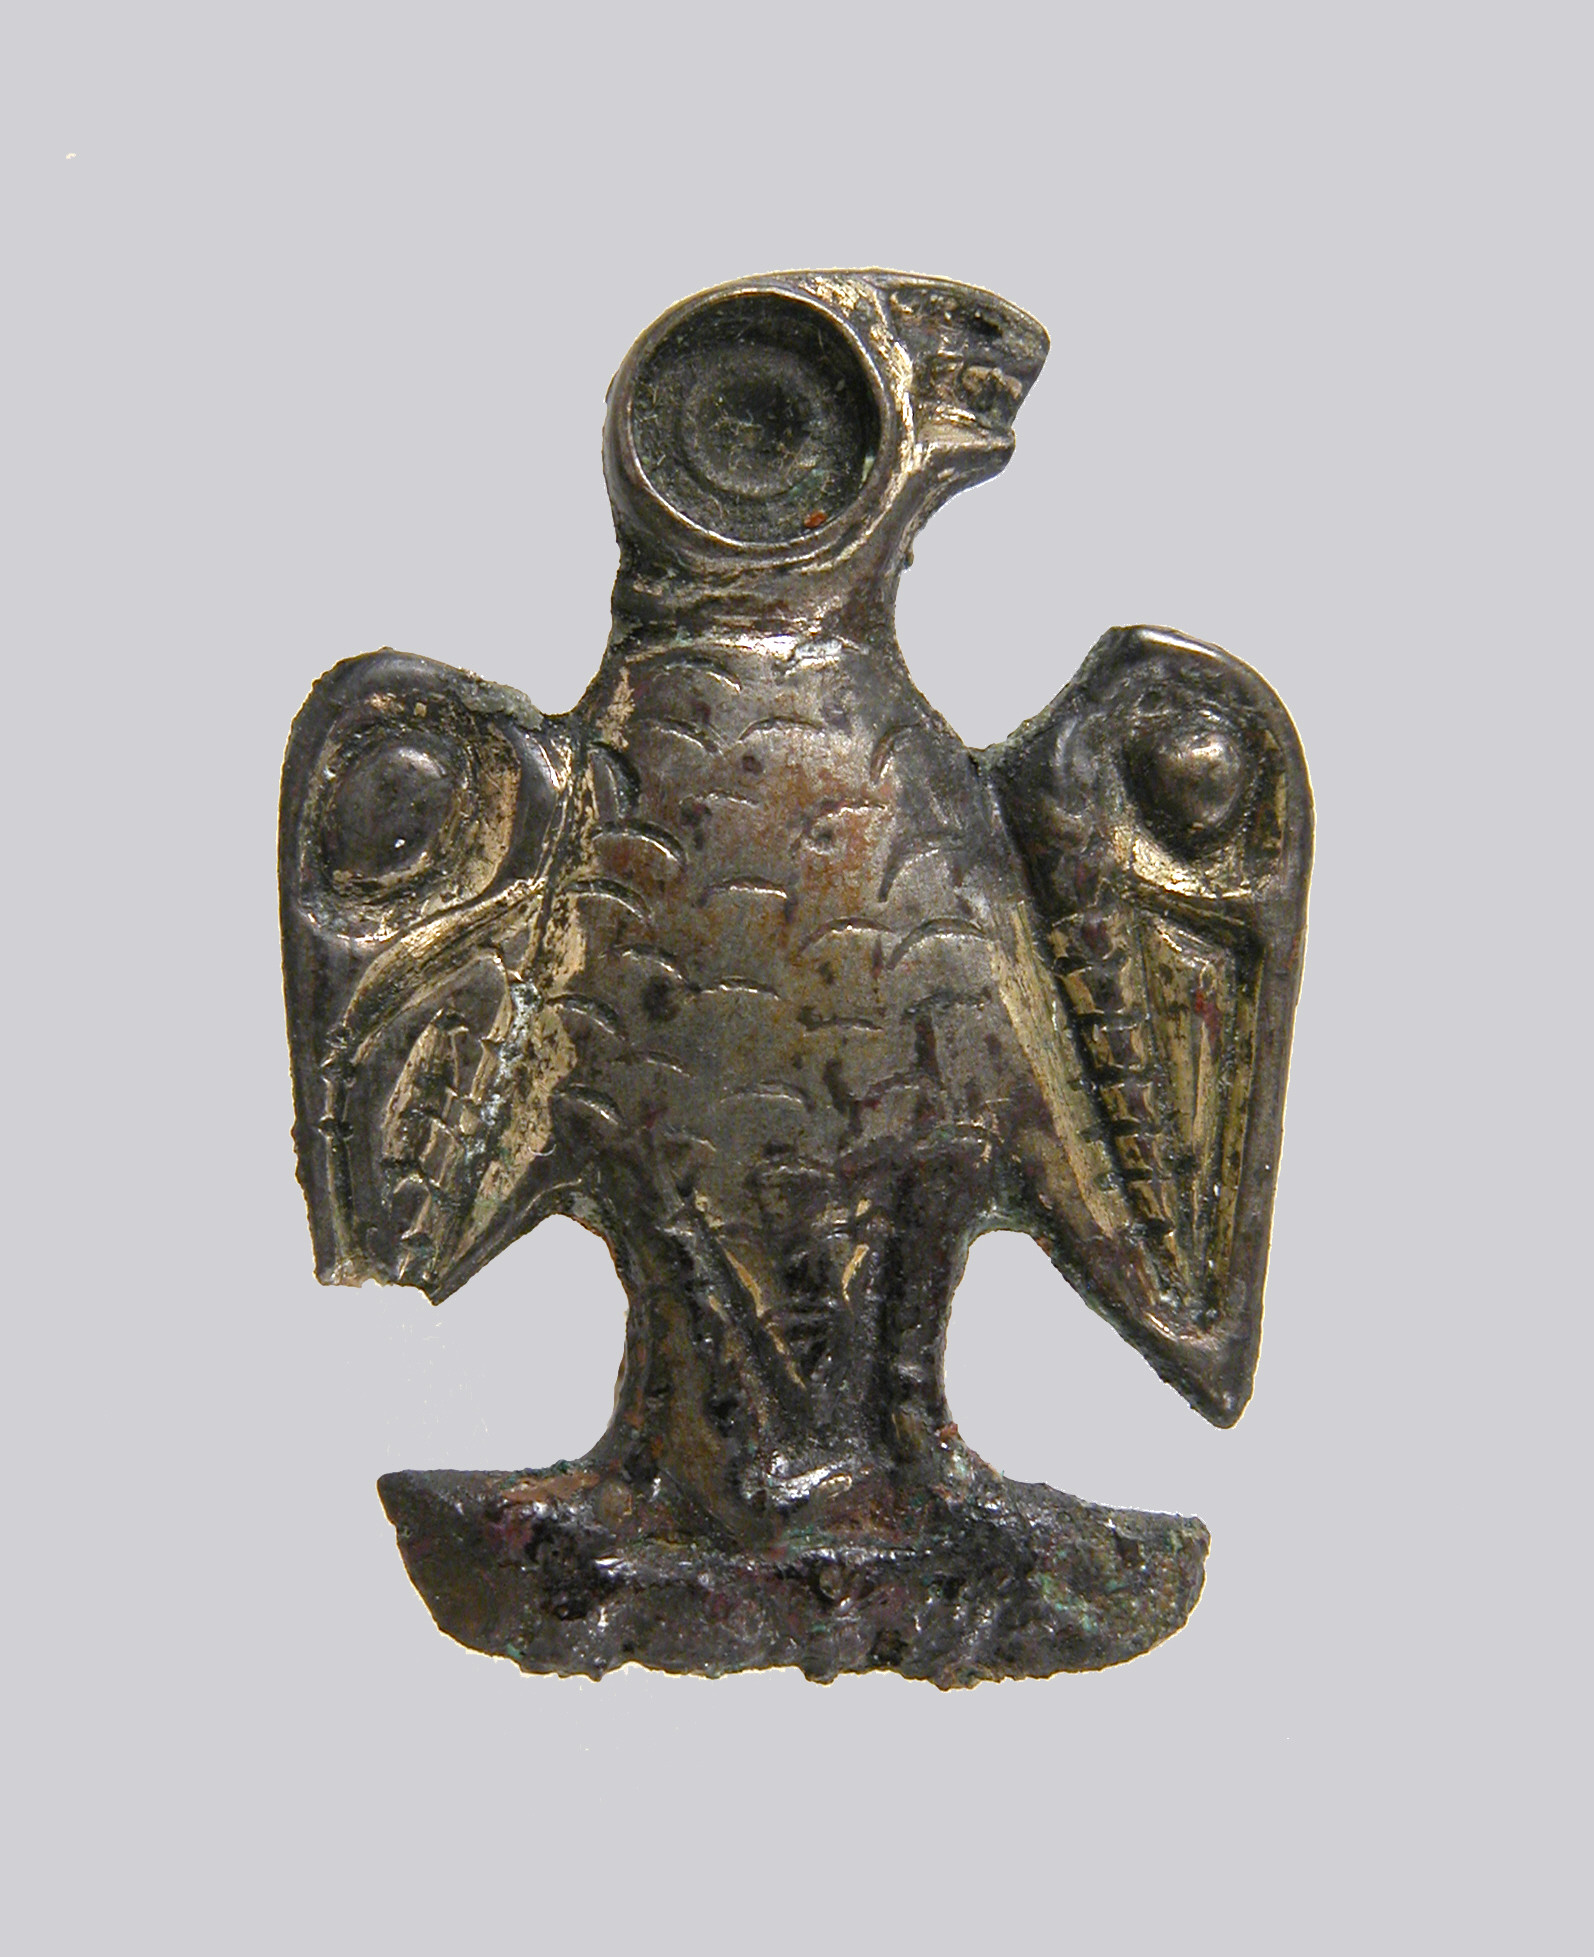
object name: brooch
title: Bird-Shaped Brooch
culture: frankish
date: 567-633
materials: silver gilt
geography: northern france